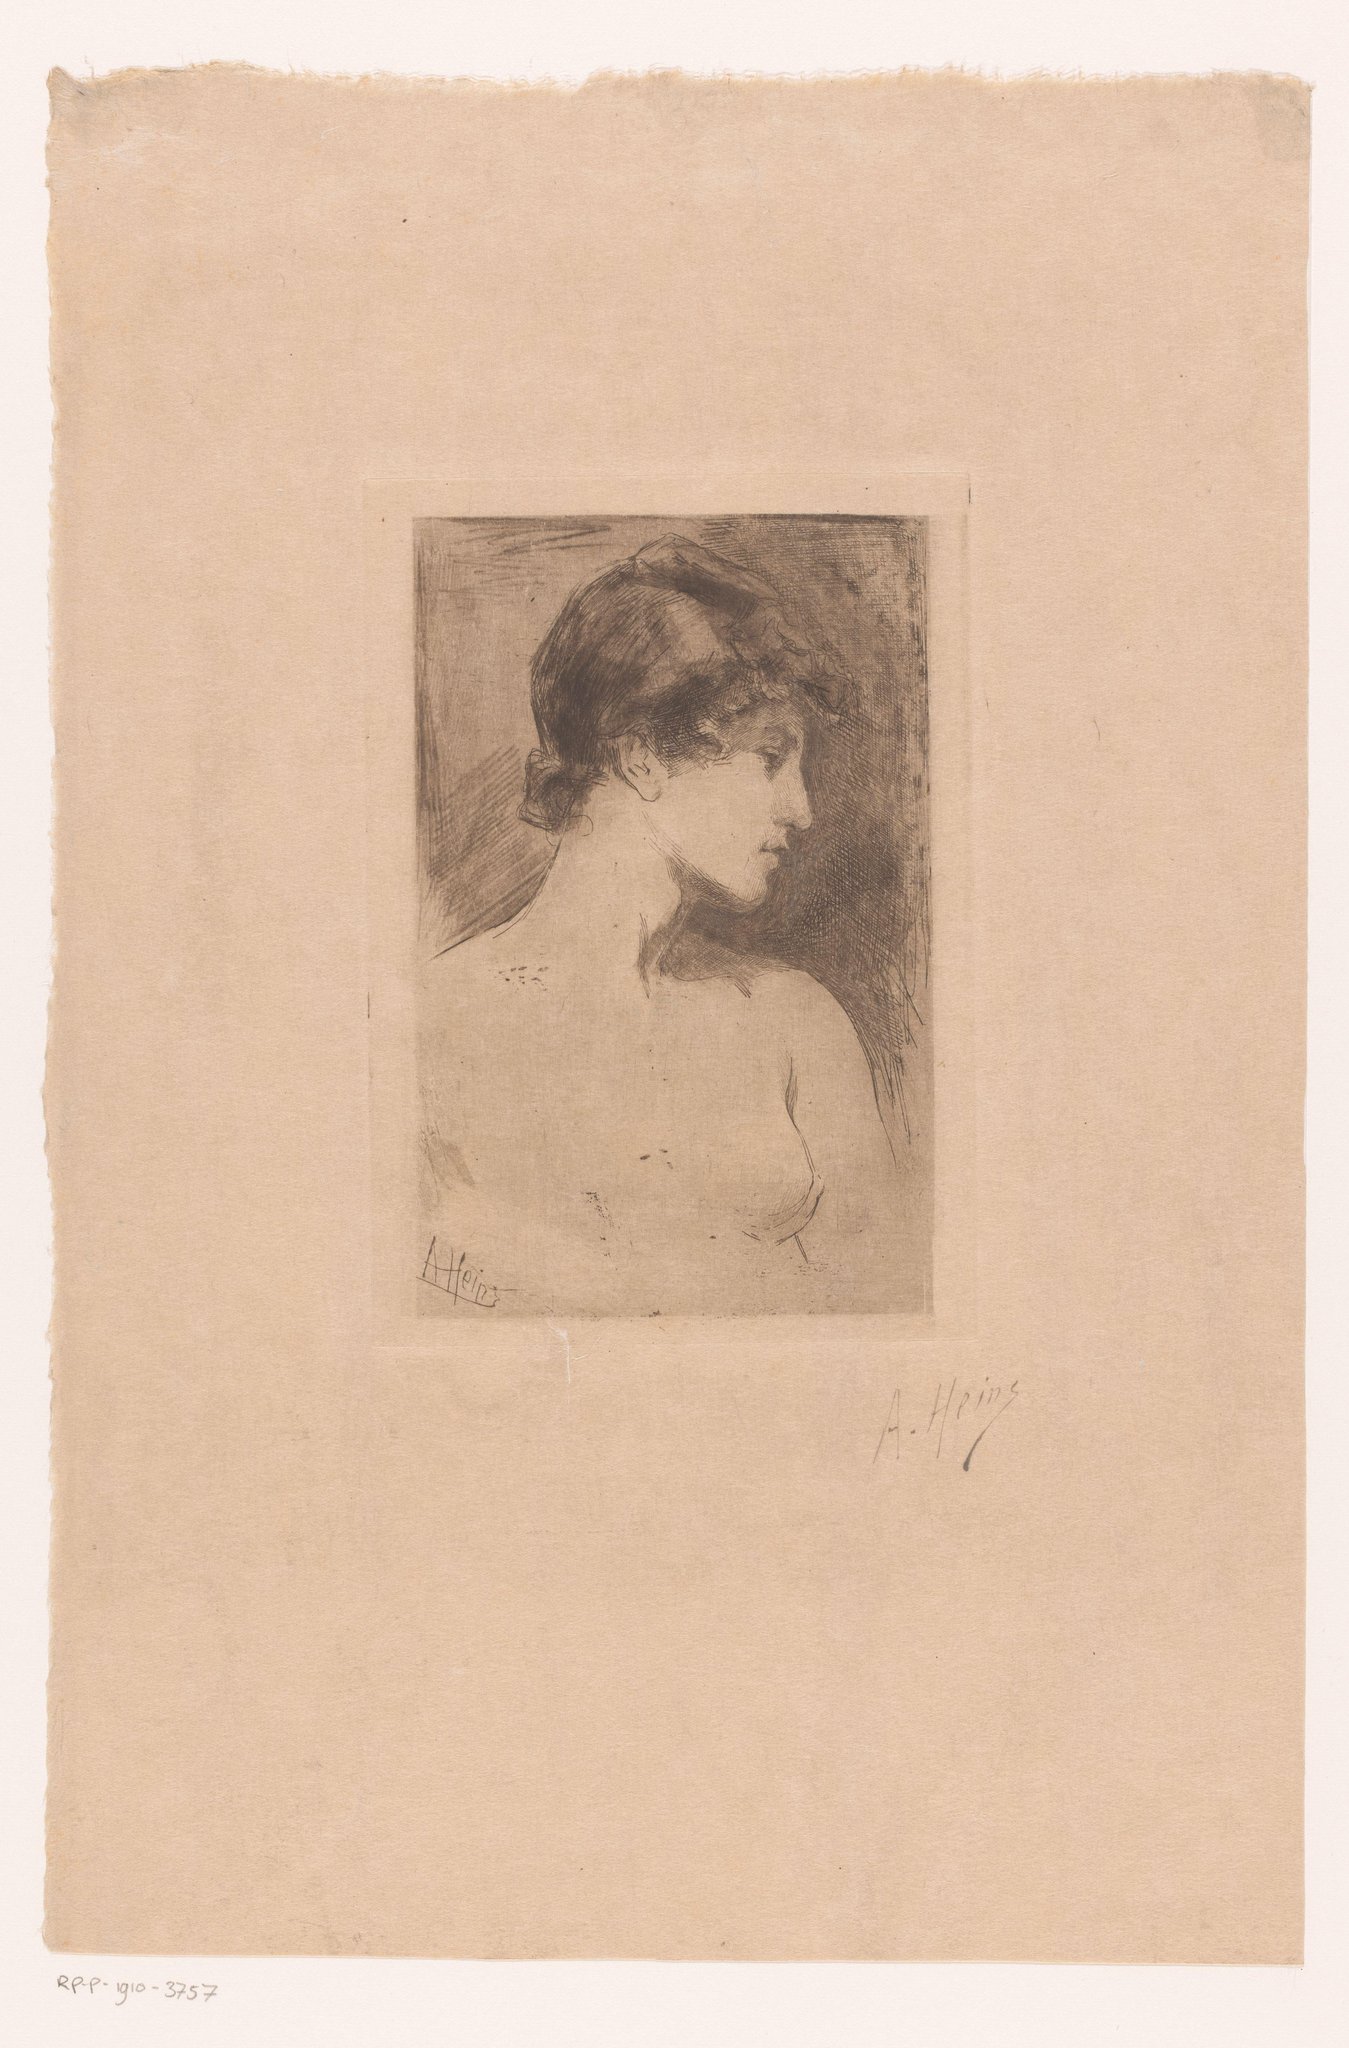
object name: print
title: Buste van een naakte vrouw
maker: armand heins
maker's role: print maker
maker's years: 1856-1938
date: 1866-1910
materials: paper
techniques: etching, intaglio, roulette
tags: adult woman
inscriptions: collector's mark: Lugt 2228